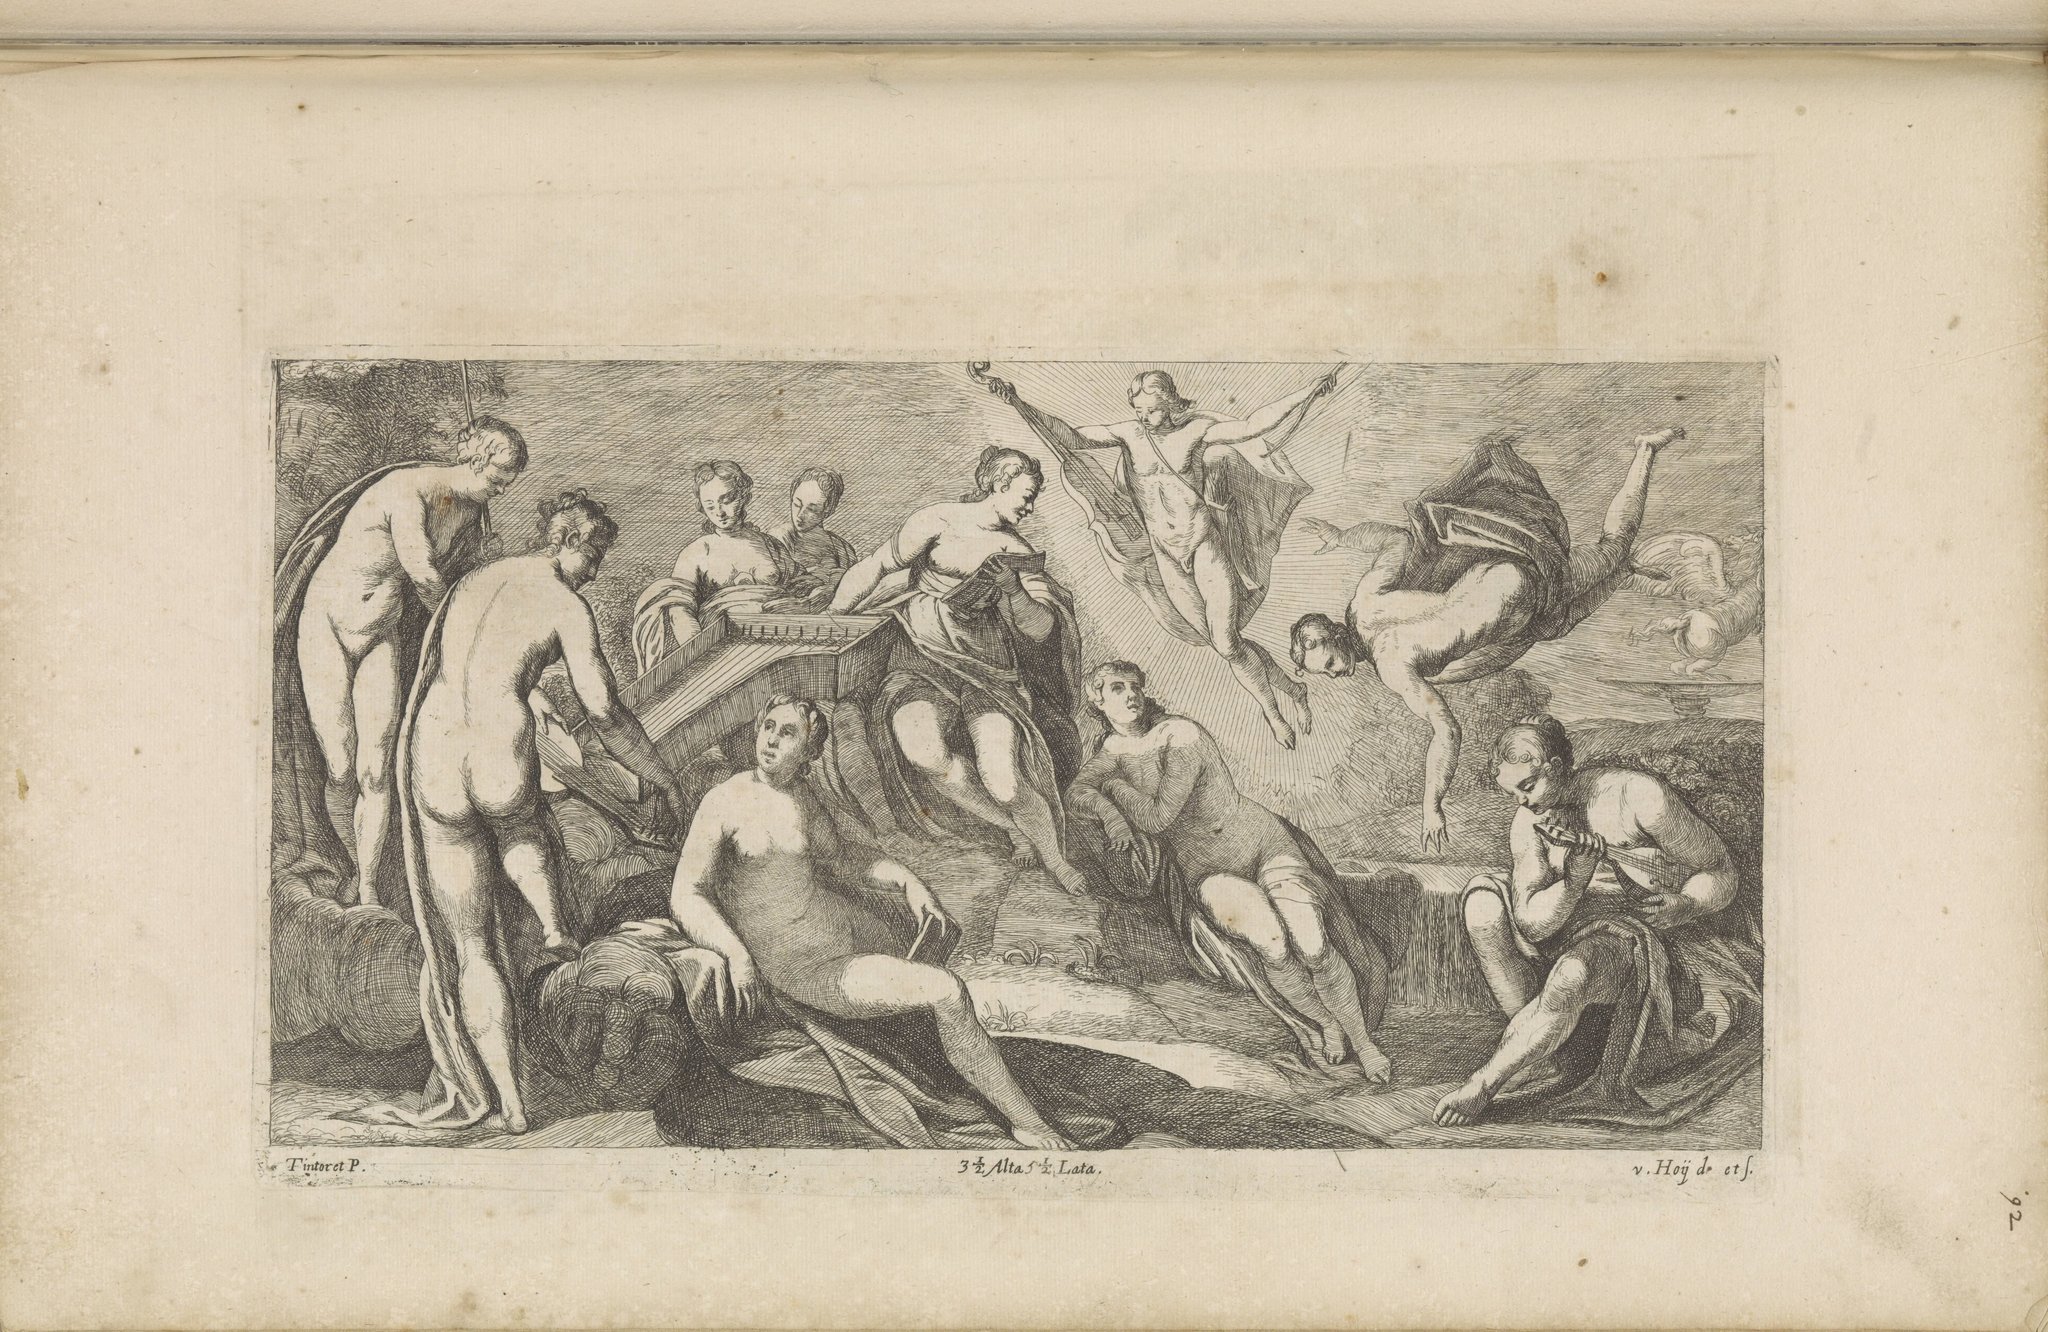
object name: print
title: Apollo en de muzen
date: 1660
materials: paper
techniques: etching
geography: brussels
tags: apollo and the muses, apollo musagetes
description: David Teniers heeft waarschijnlijk van alle schilderijen uit de collectie van Leopold Willem van Oostenrijk een olieverfstudie op doek of paneel vervaardigd (zgn. pasticcio), die als voorbeeld voor de prentmakers diende. Het is niet altijd duidelijk of de pasticci door hem zijn gemaakt of door zijn atelier. Niet alle pasticci zijn overgeleverd.